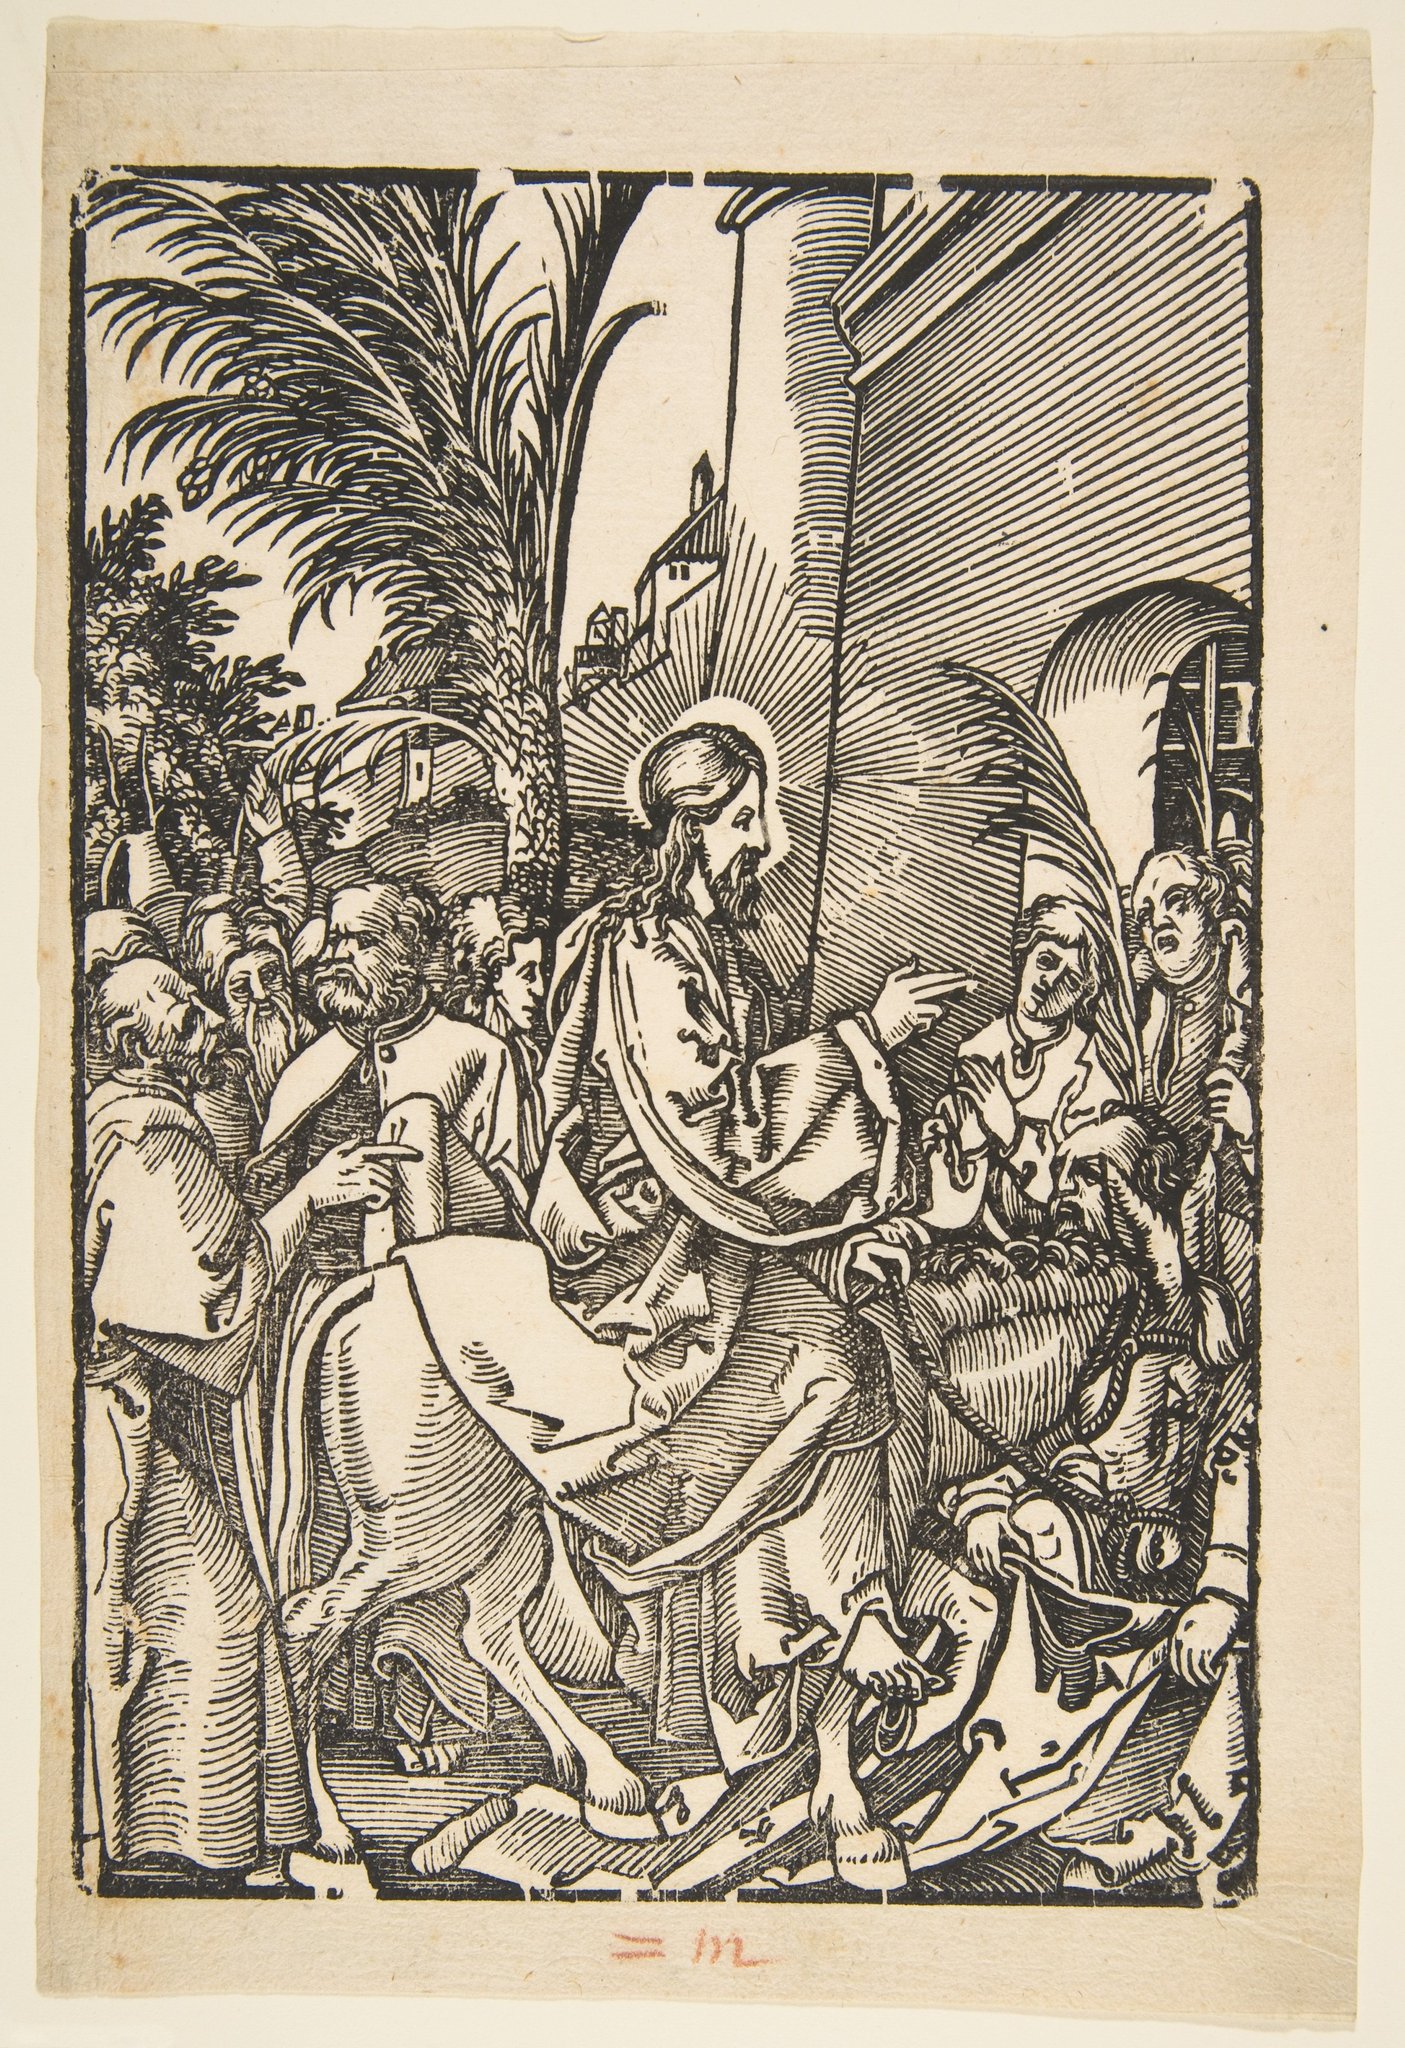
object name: print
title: Christ's Entry into Jerusalem, from The Small Passion (copy)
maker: albrecht dürer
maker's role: artist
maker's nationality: german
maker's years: 1471-1528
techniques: woodcut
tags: horses,christ